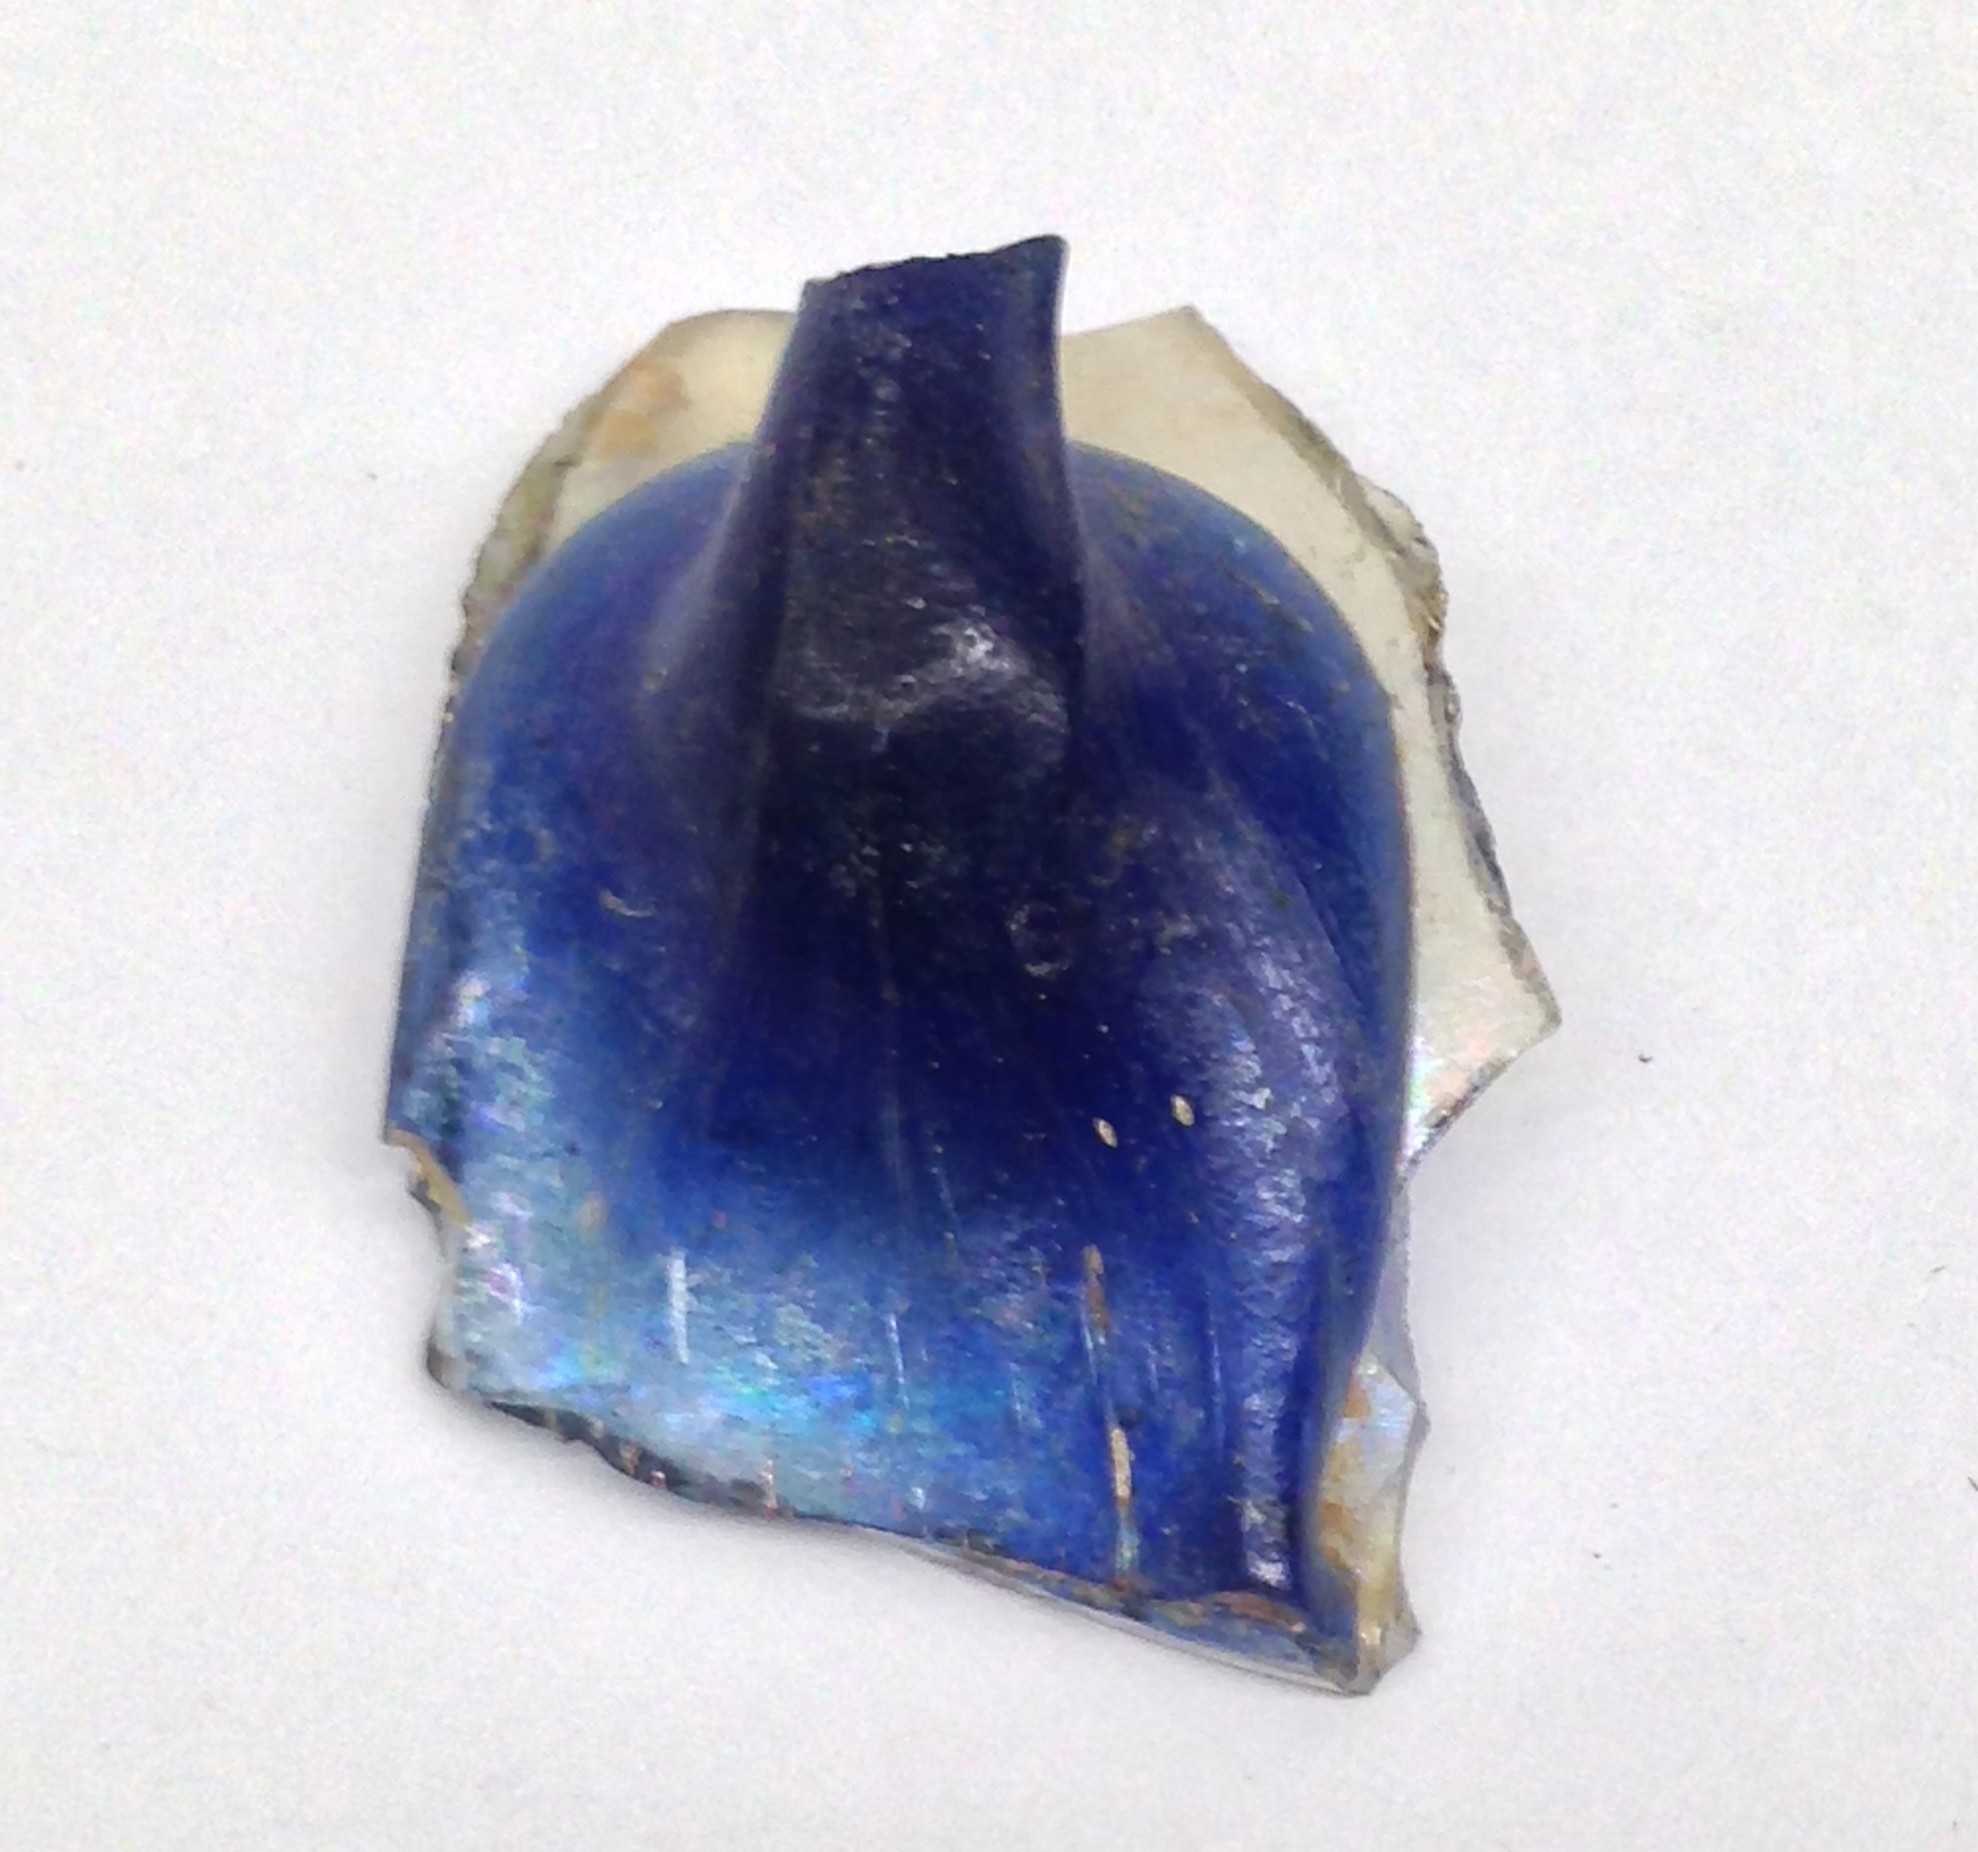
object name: lamp fragment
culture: syrian or crusader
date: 1201-1300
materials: glass